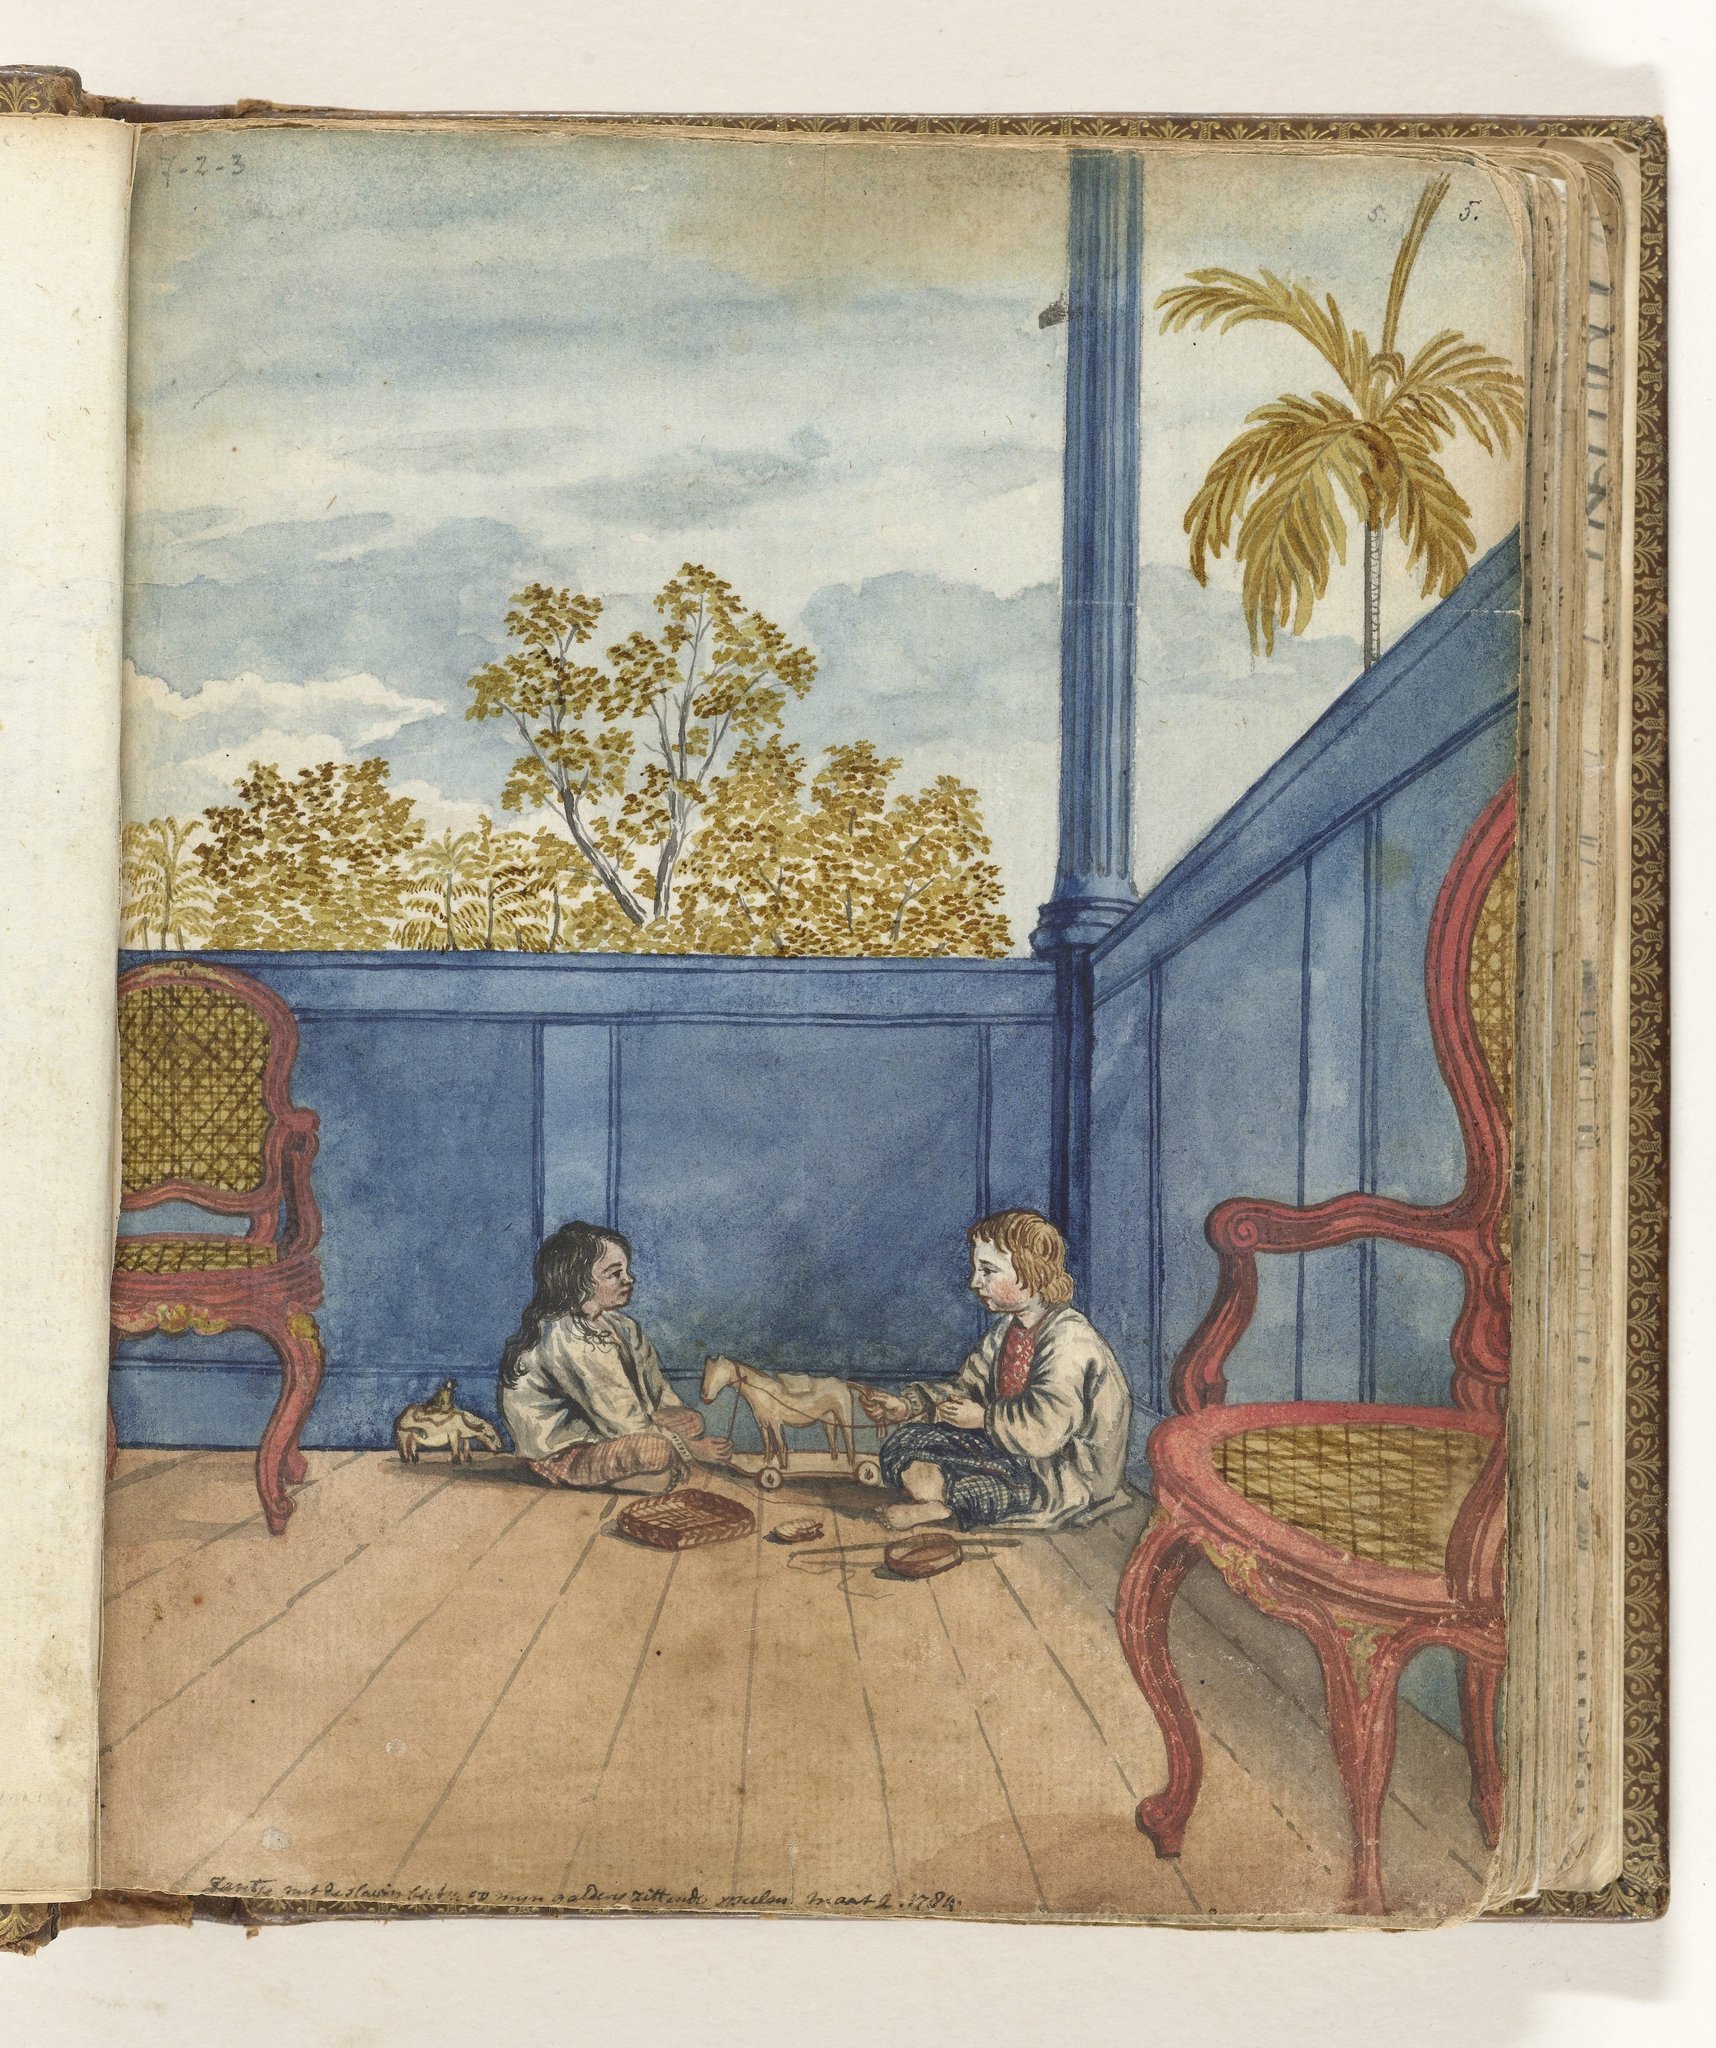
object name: drawing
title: Galerij met zoon Jantje en Bietja, een tot slaaf gemaakt meisje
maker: jan brandes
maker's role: draughtsman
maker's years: 1743-1808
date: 1784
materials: paper, pencil, watercolor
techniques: brush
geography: jakarta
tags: bodegraven, draughtsman, jan brandes, batavia, slavery; serfs and enslaved persons, loggia, verandah, porch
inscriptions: inscription: ‘Jantje met de slavin bietja op myn galdery zittende speelen maart 2. 1784.’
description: Kleurtekening van de open galerij aan het huis van de tekenaar Jan Brandes met twee stoelen. Op de vloer tussen het speelgoed (houten paard en karbouw) zitten zoon Jantje en Bietja, een tot slaaf gemaakt meisje. Met opschrift. Onderdeel uit het schetsboek van Jan Brandes, dl. 2 (1808), p. 5.